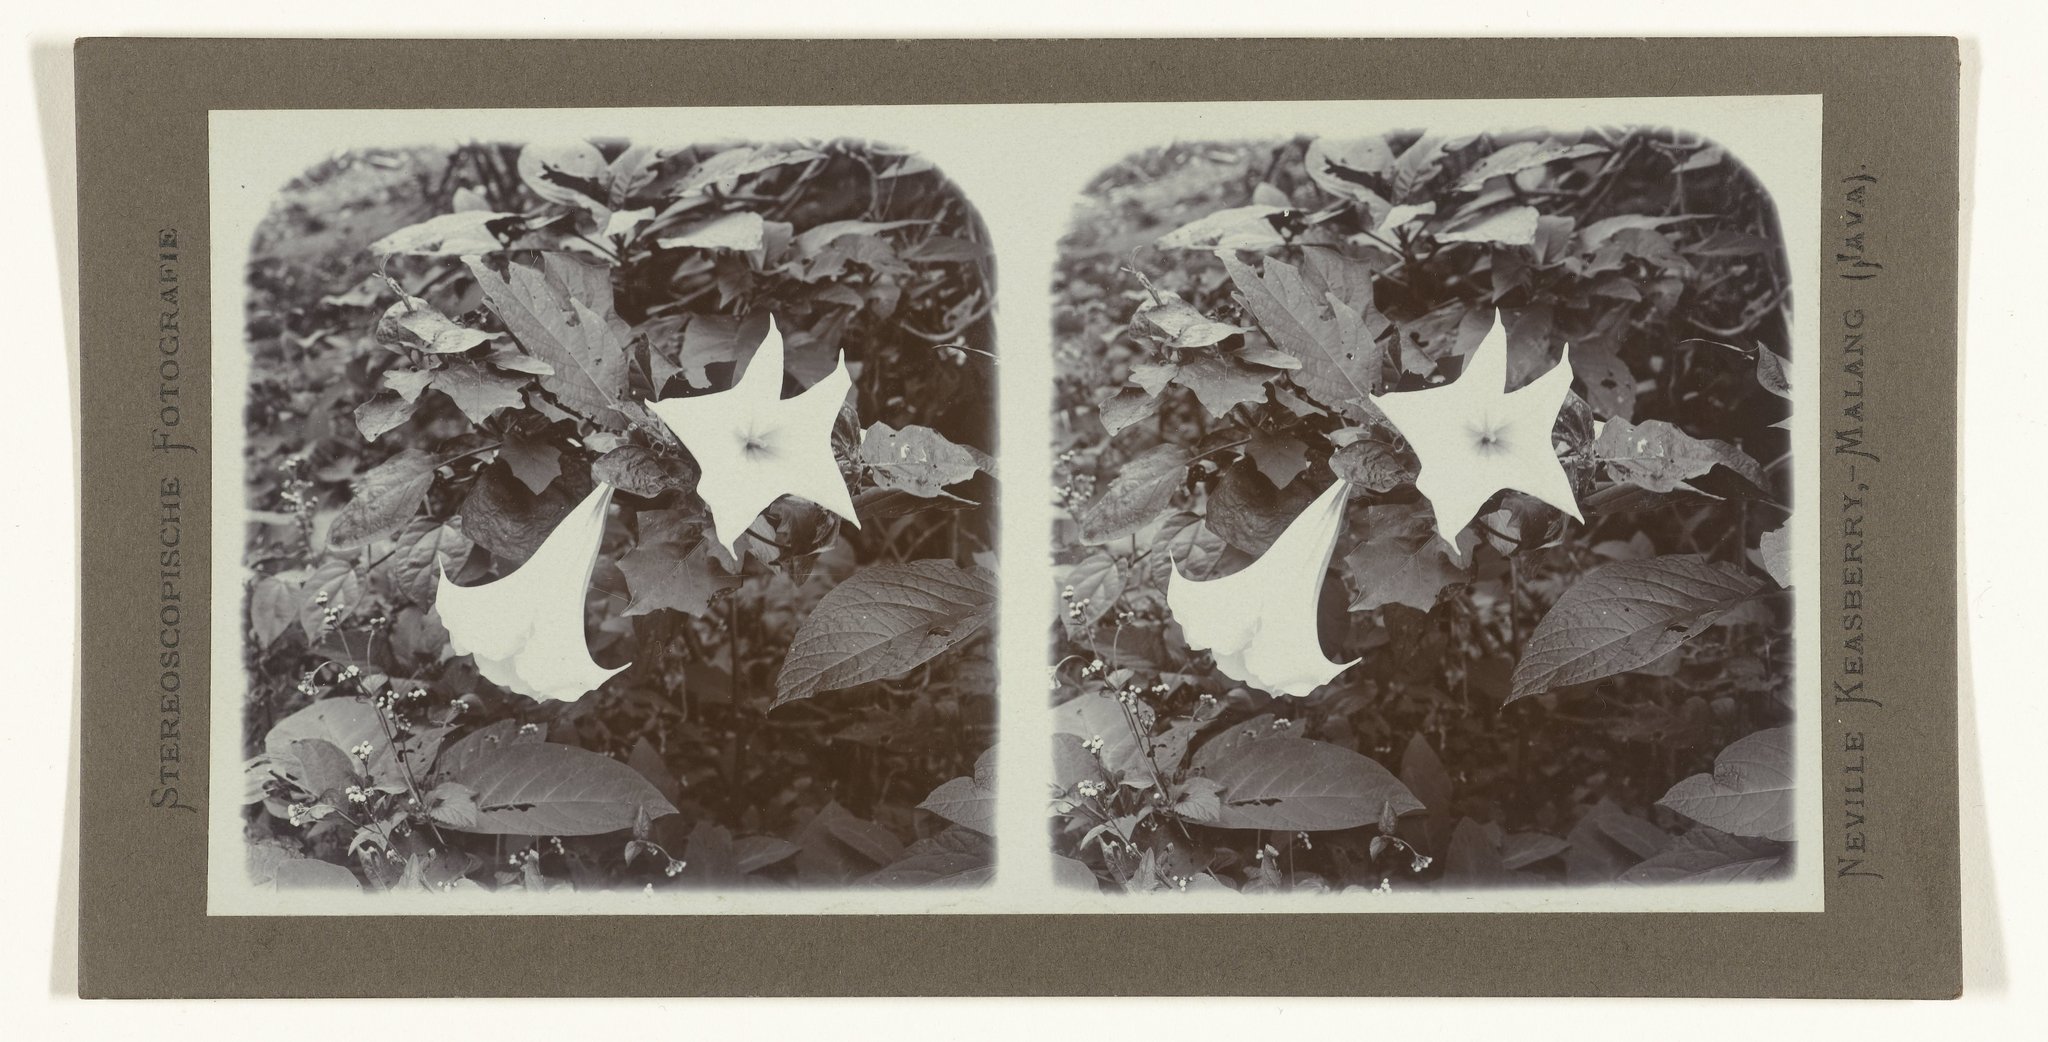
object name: stereograph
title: Ketjoeboong bloemen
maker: neville keasberry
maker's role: fotograaf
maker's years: 1866-1944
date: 1900-1935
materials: cardboard, paper, photographic support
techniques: albumen print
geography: malang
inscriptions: inscription: ‘Stereoscopische Fotografie’, signature: ‘Neville Keasberry, Malang (Java)’, annotation: ‘S 8 No 88. Ketjoeboong bloemen.’